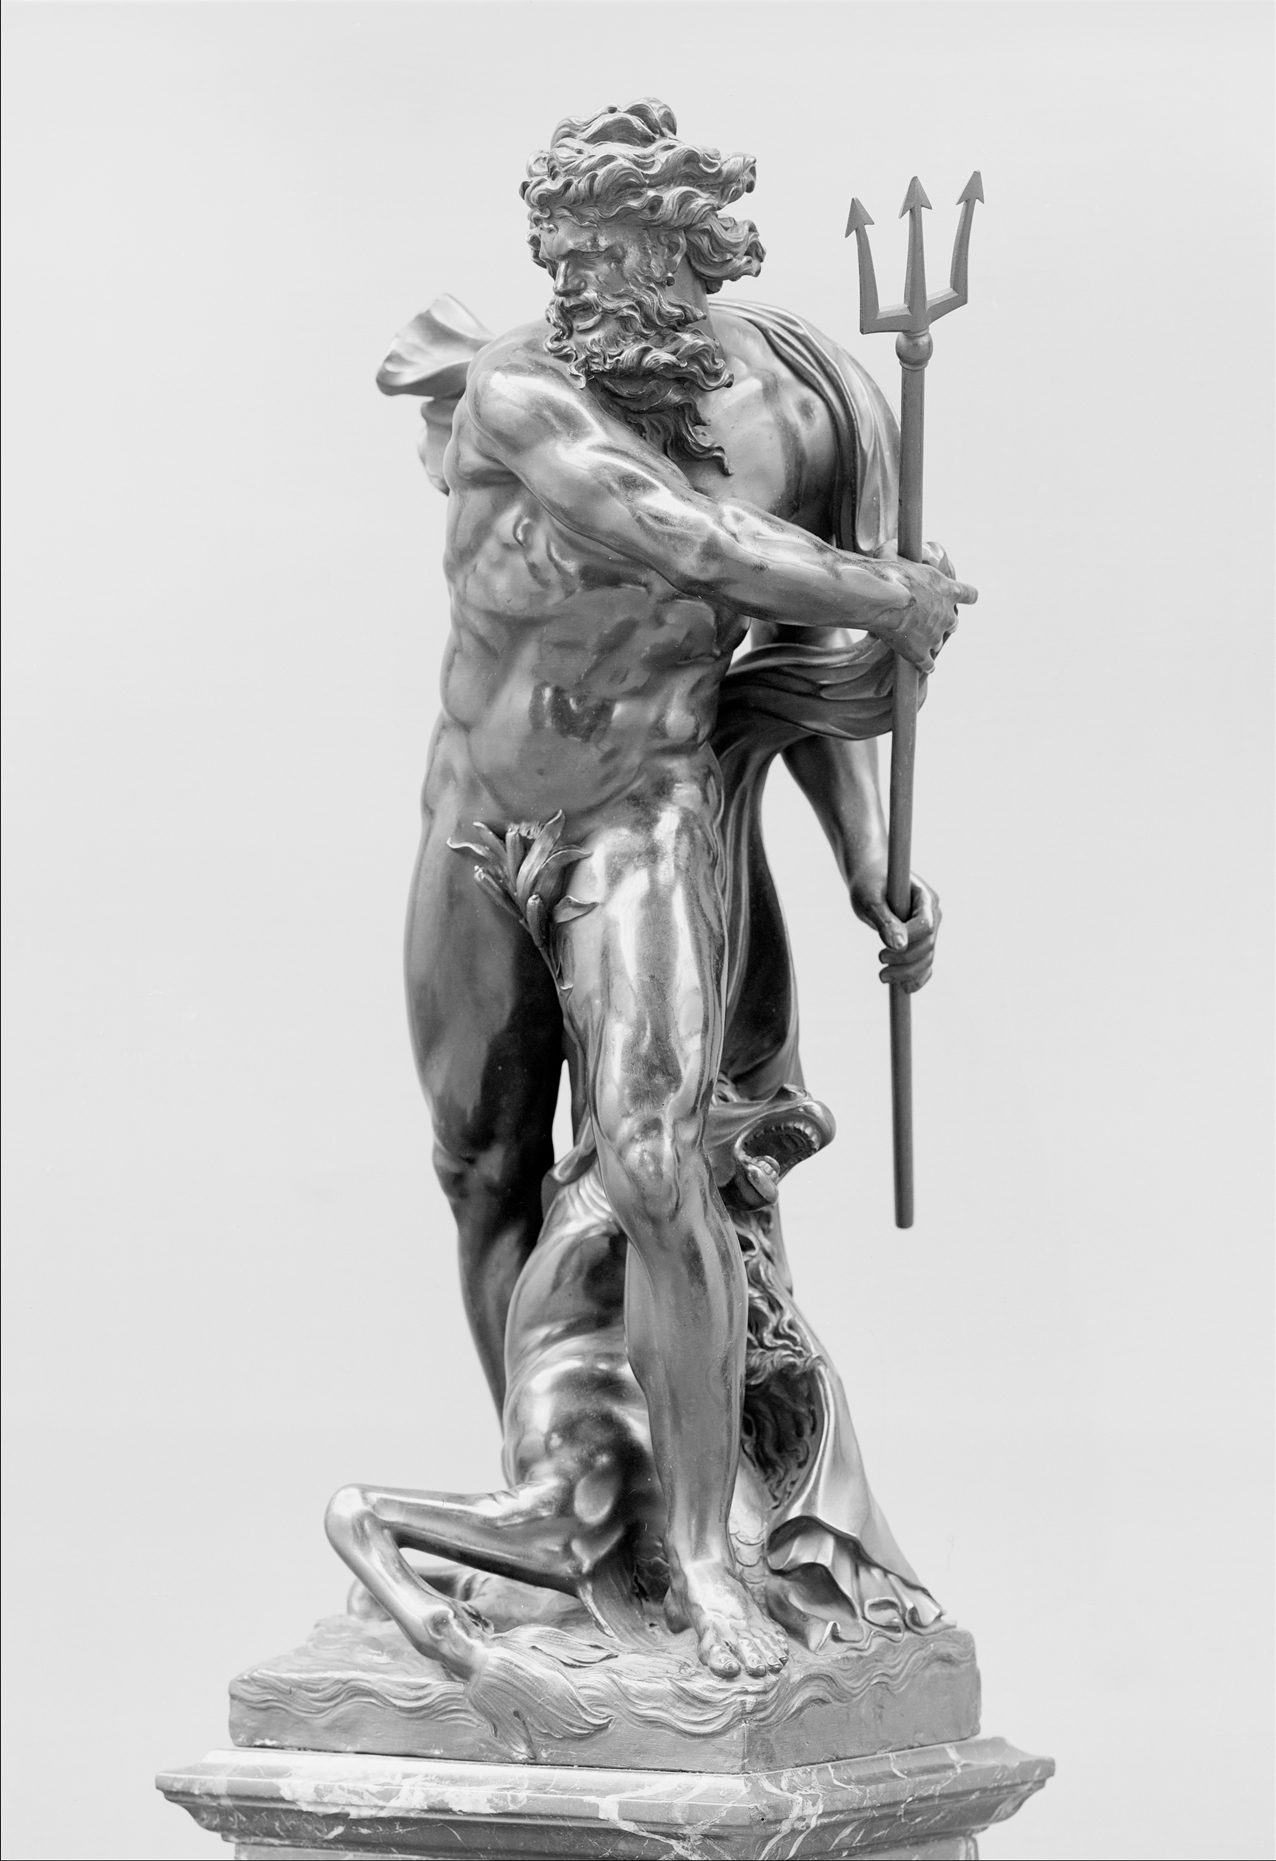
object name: statuette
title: Neptune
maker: michel anguier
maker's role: artist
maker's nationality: french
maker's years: 1612-1686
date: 1701-1900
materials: bronze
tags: neptune,seahorses